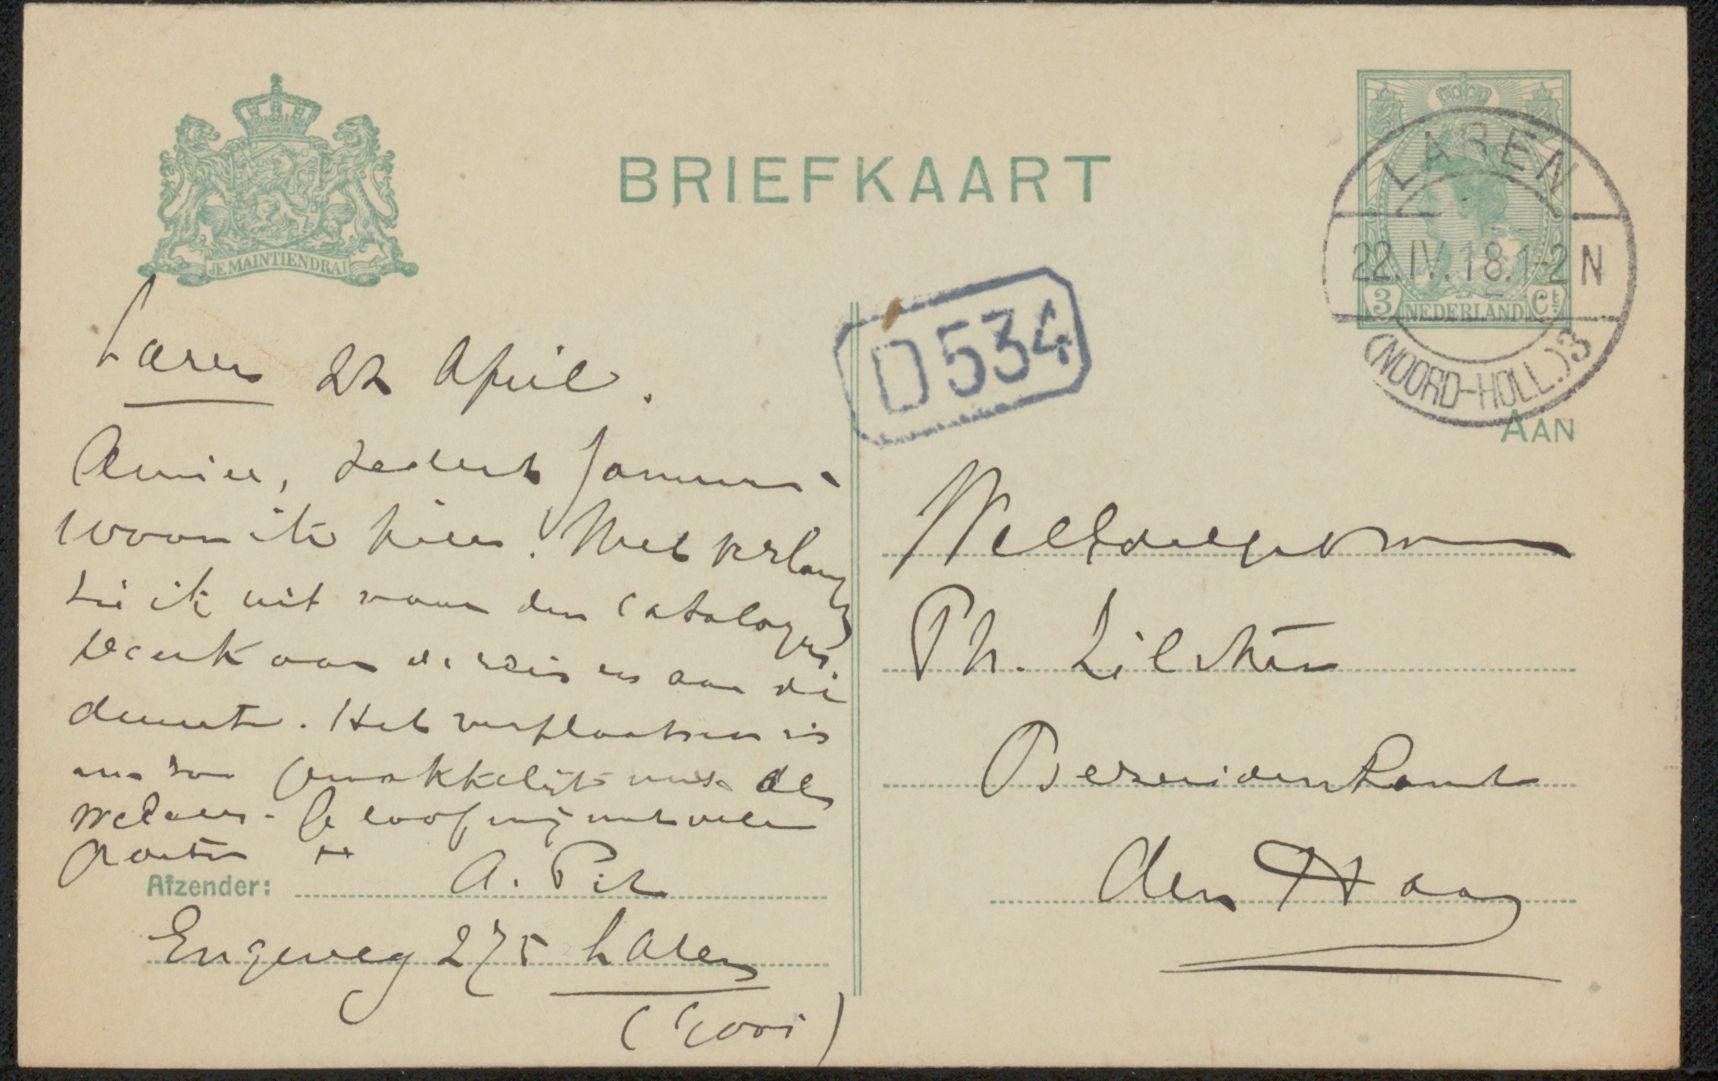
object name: postcard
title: Briefkaart aan Philip Zilcken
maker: adriaan pit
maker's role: print maker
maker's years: 1860-1944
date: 1918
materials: cardboard, ink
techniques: pen, writing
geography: laren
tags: the hague, painter, draughtsman, philip zilcken, printed matter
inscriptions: collector's mark: ‘RPK’